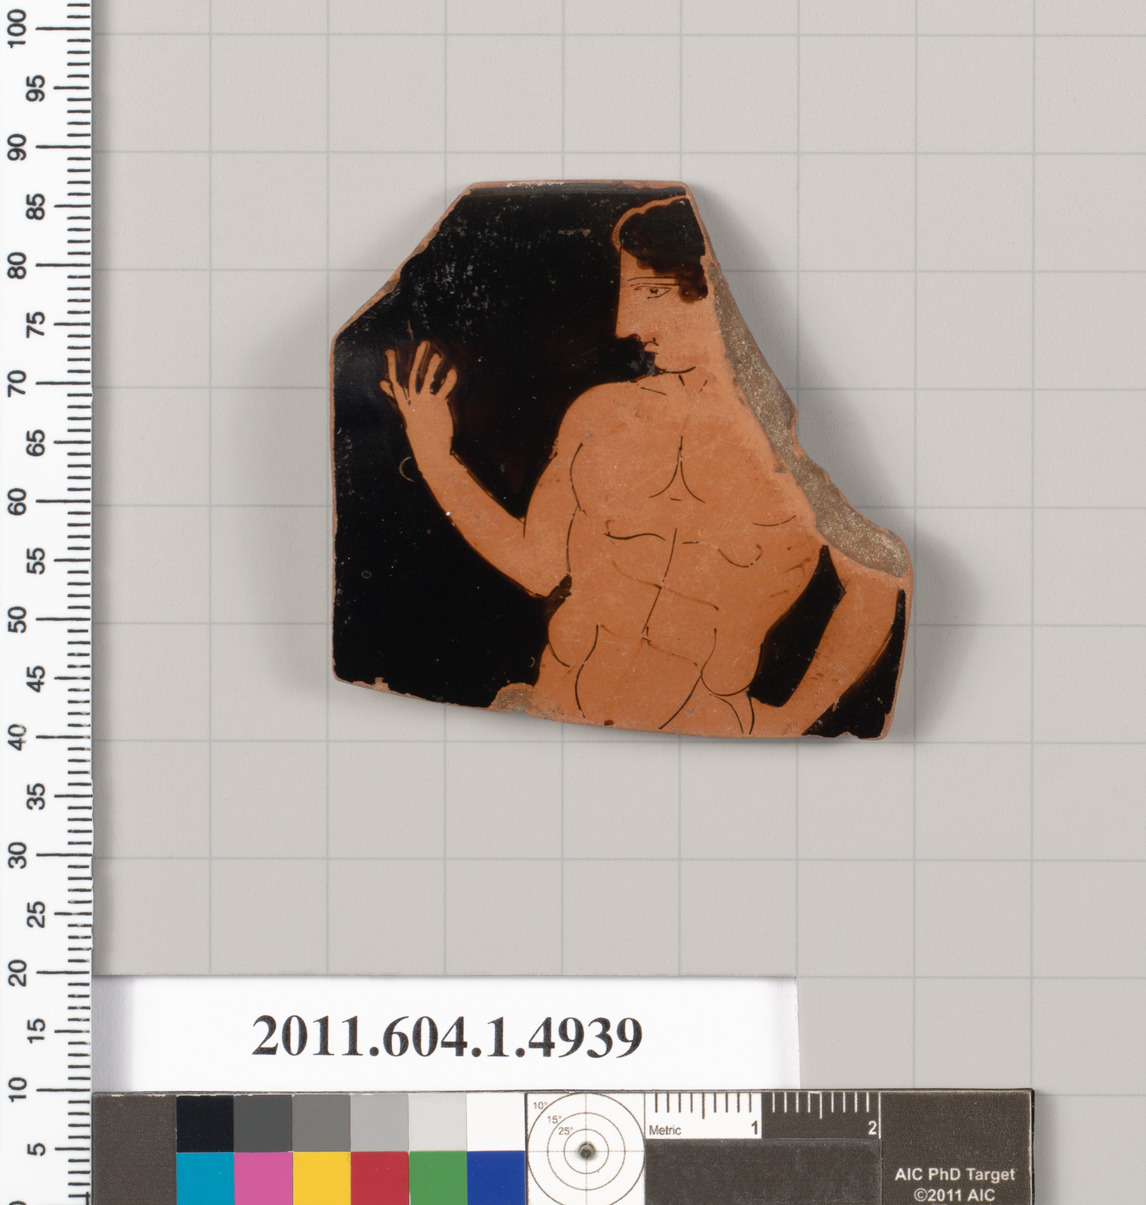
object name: kylix fragment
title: Terracotta rim fragment of a kylix (drinking cup)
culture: greek, attic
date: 470-460 BCE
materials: terracotta